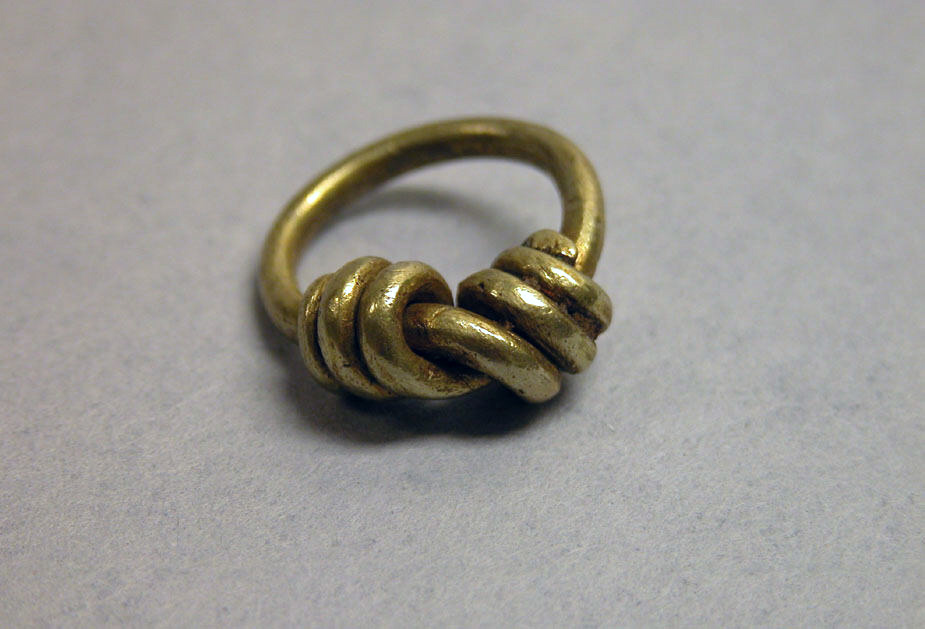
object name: ring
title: Knotted Wire-coiled Ring with Solid Hoop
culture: indonesian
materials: gold